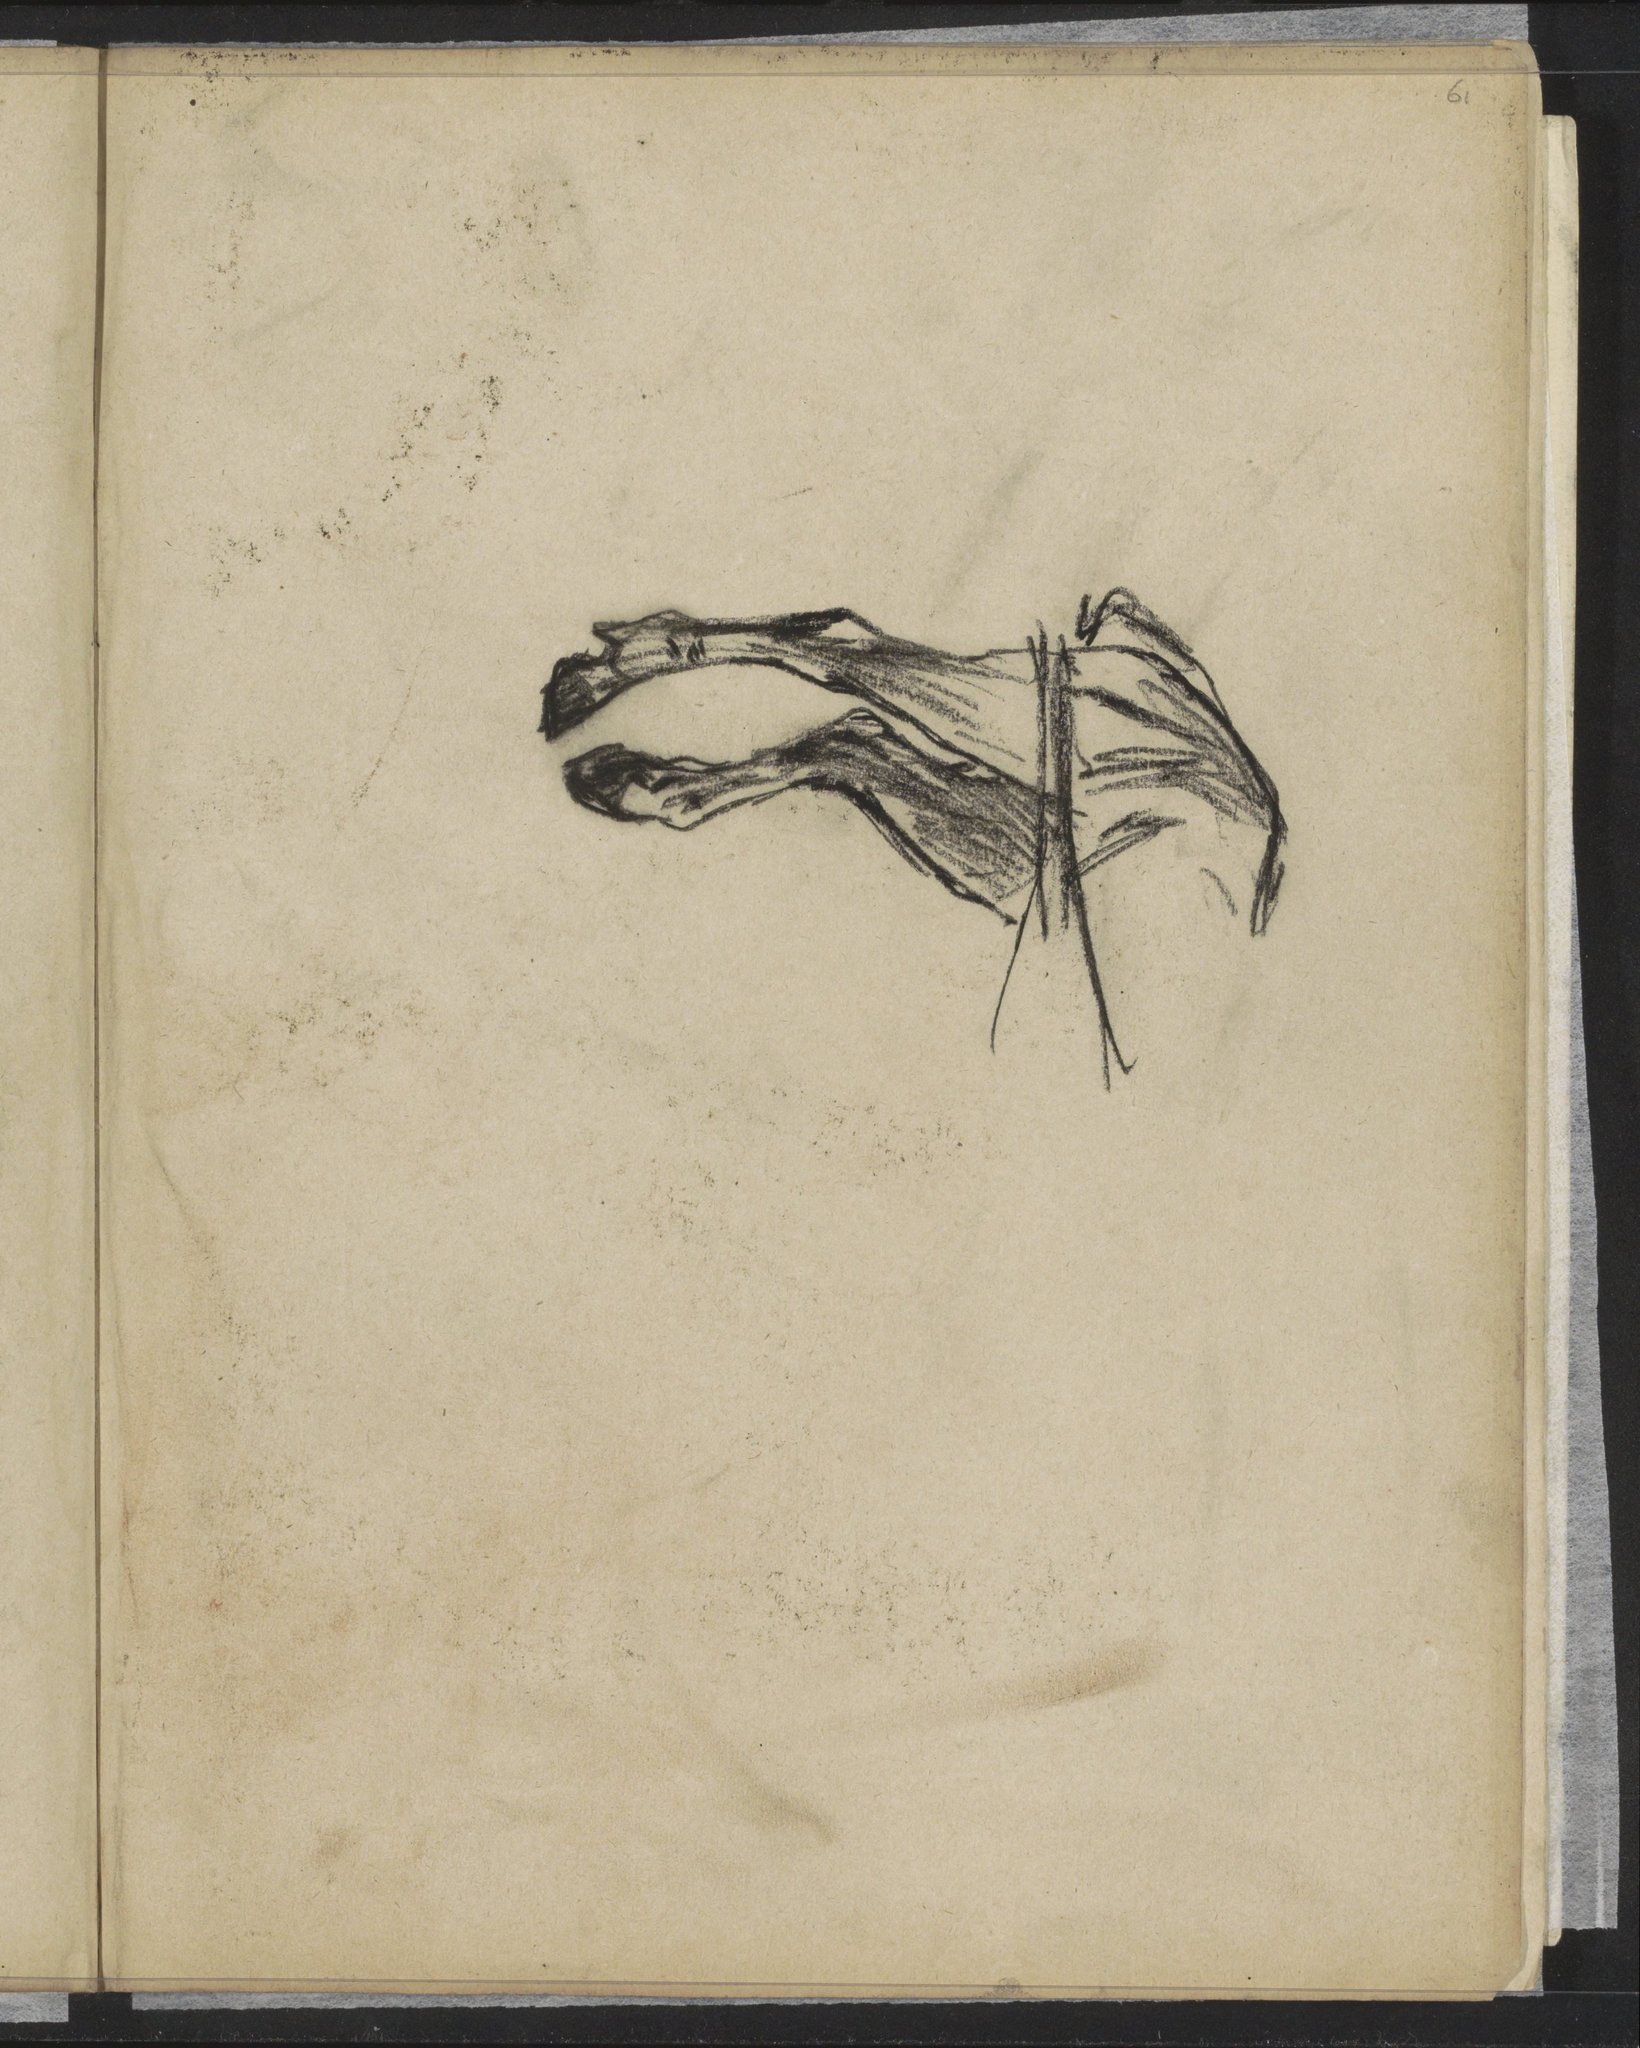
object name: sketchbook leaf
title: Achterlijf van een aangespannen paard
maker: willem witsen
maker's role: draughtsman, painter, print maker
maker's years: 1860-1923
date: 1888-1890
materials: chalk, paper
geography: london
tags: horse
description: Voorstudie voor de ets 'Standplaats voor rijtuigen onder Charing Cross Bridge, Londen', 1890.